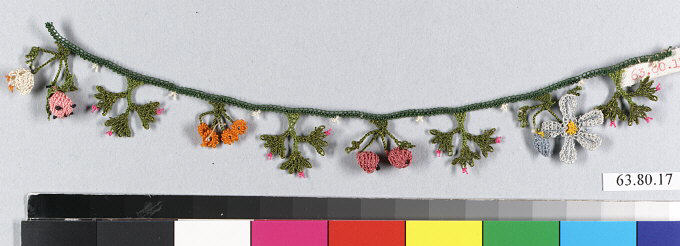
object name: piece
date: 1801-1900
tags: flowers